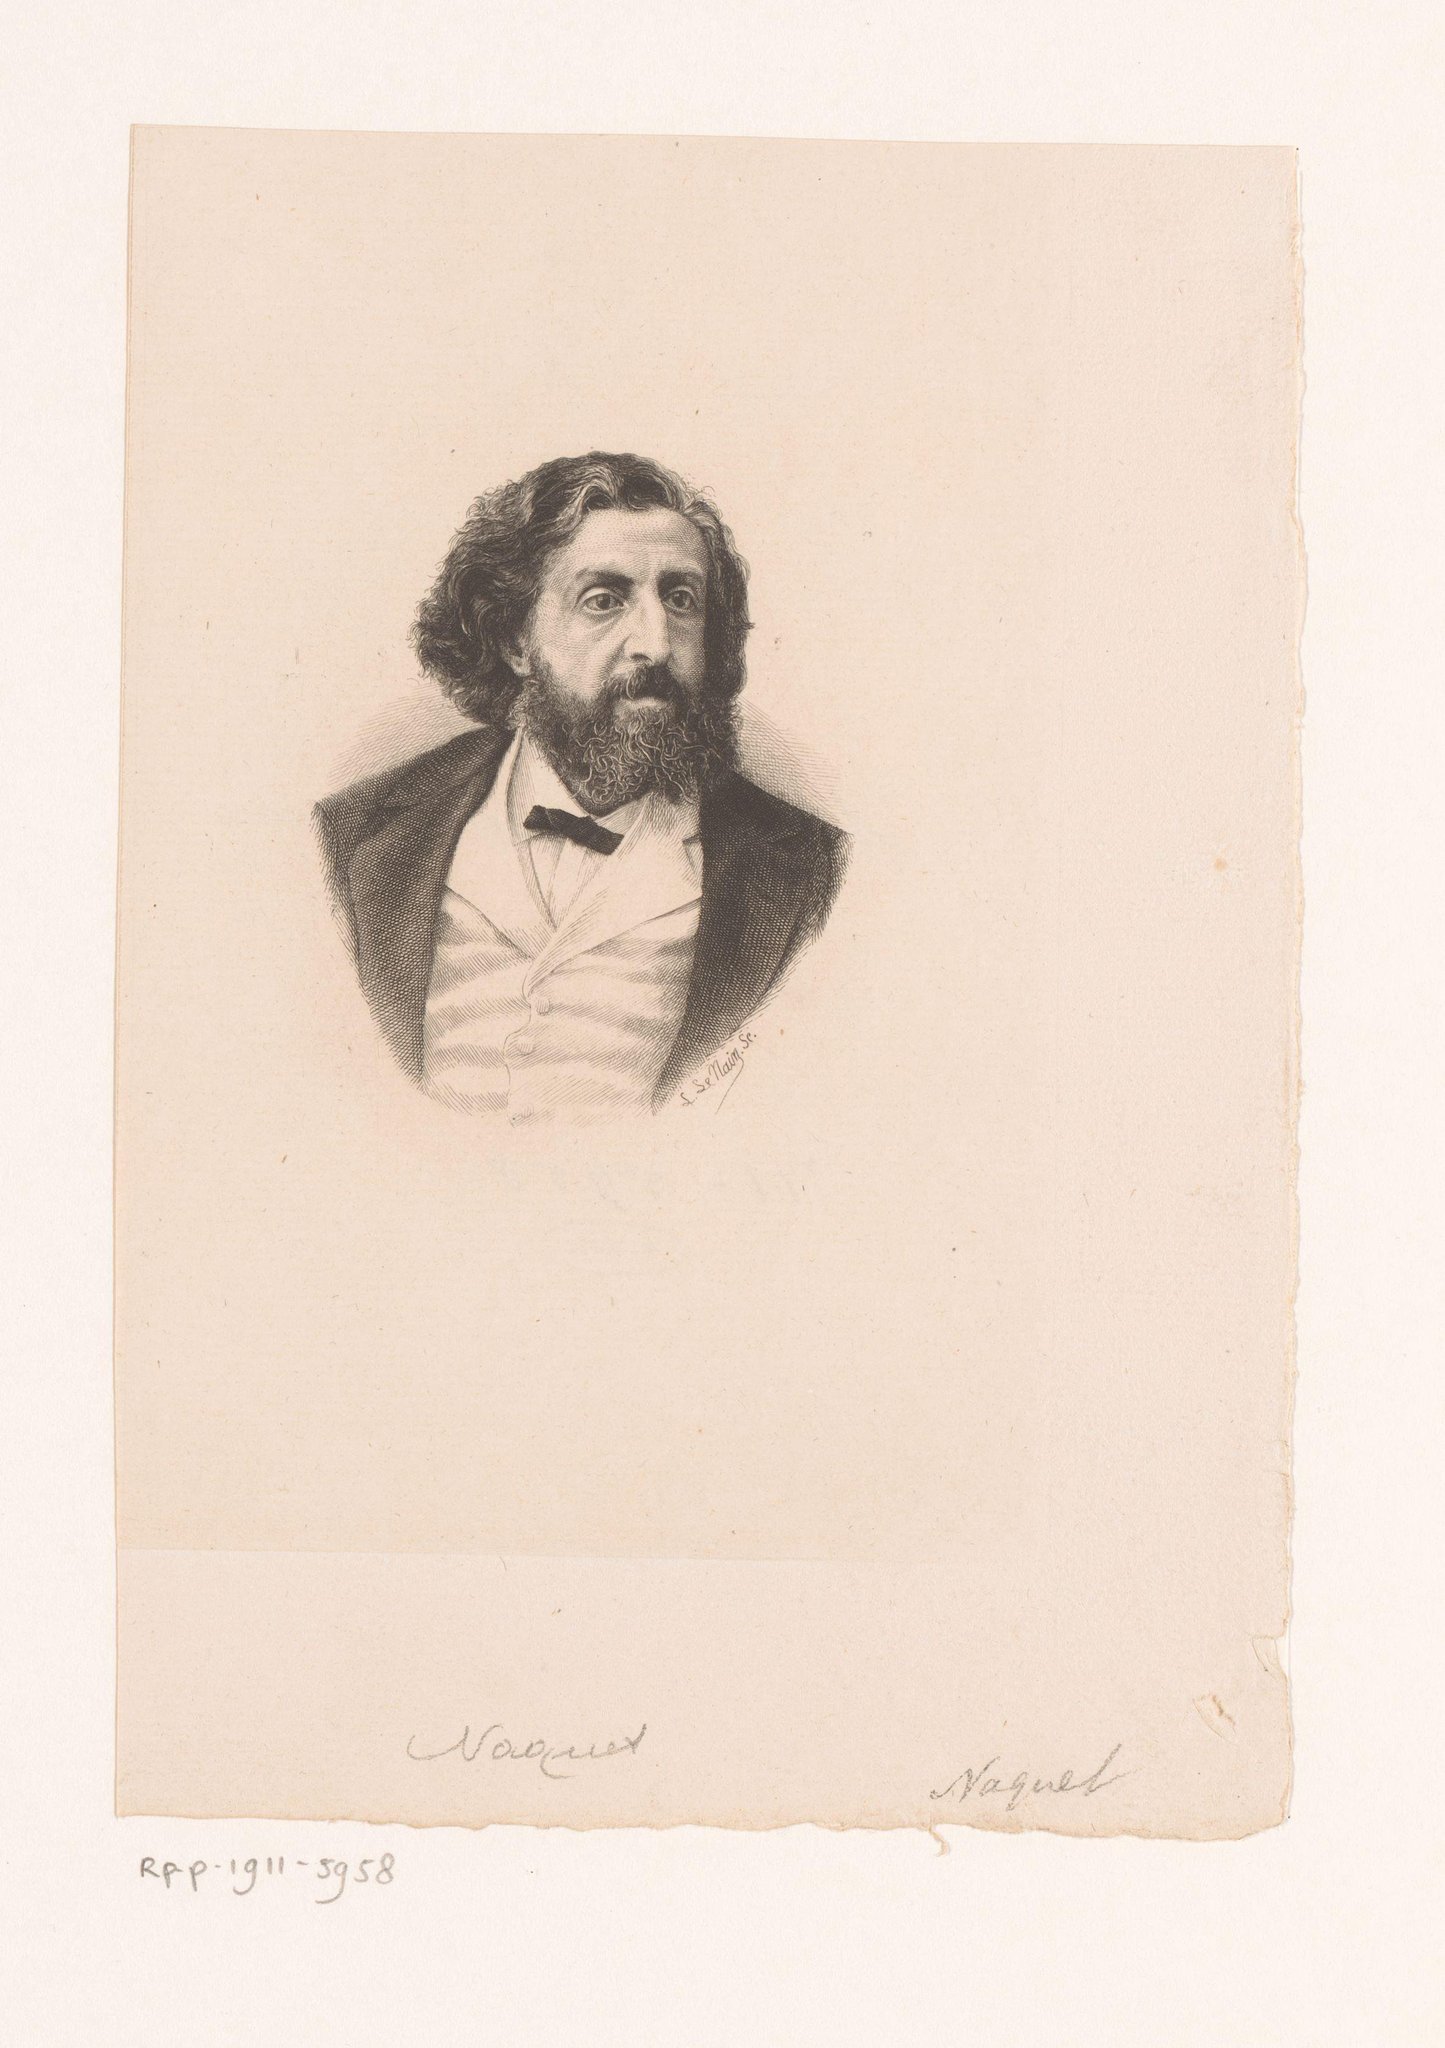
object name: print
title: Portret van Alfred Joseph Naquet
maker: louis le nain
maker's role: print maker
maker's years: 1851-1939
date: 1861-1911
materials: paper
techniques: etching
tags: adult man, historical persons, beard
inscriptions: collector's mark: Lugt 2228